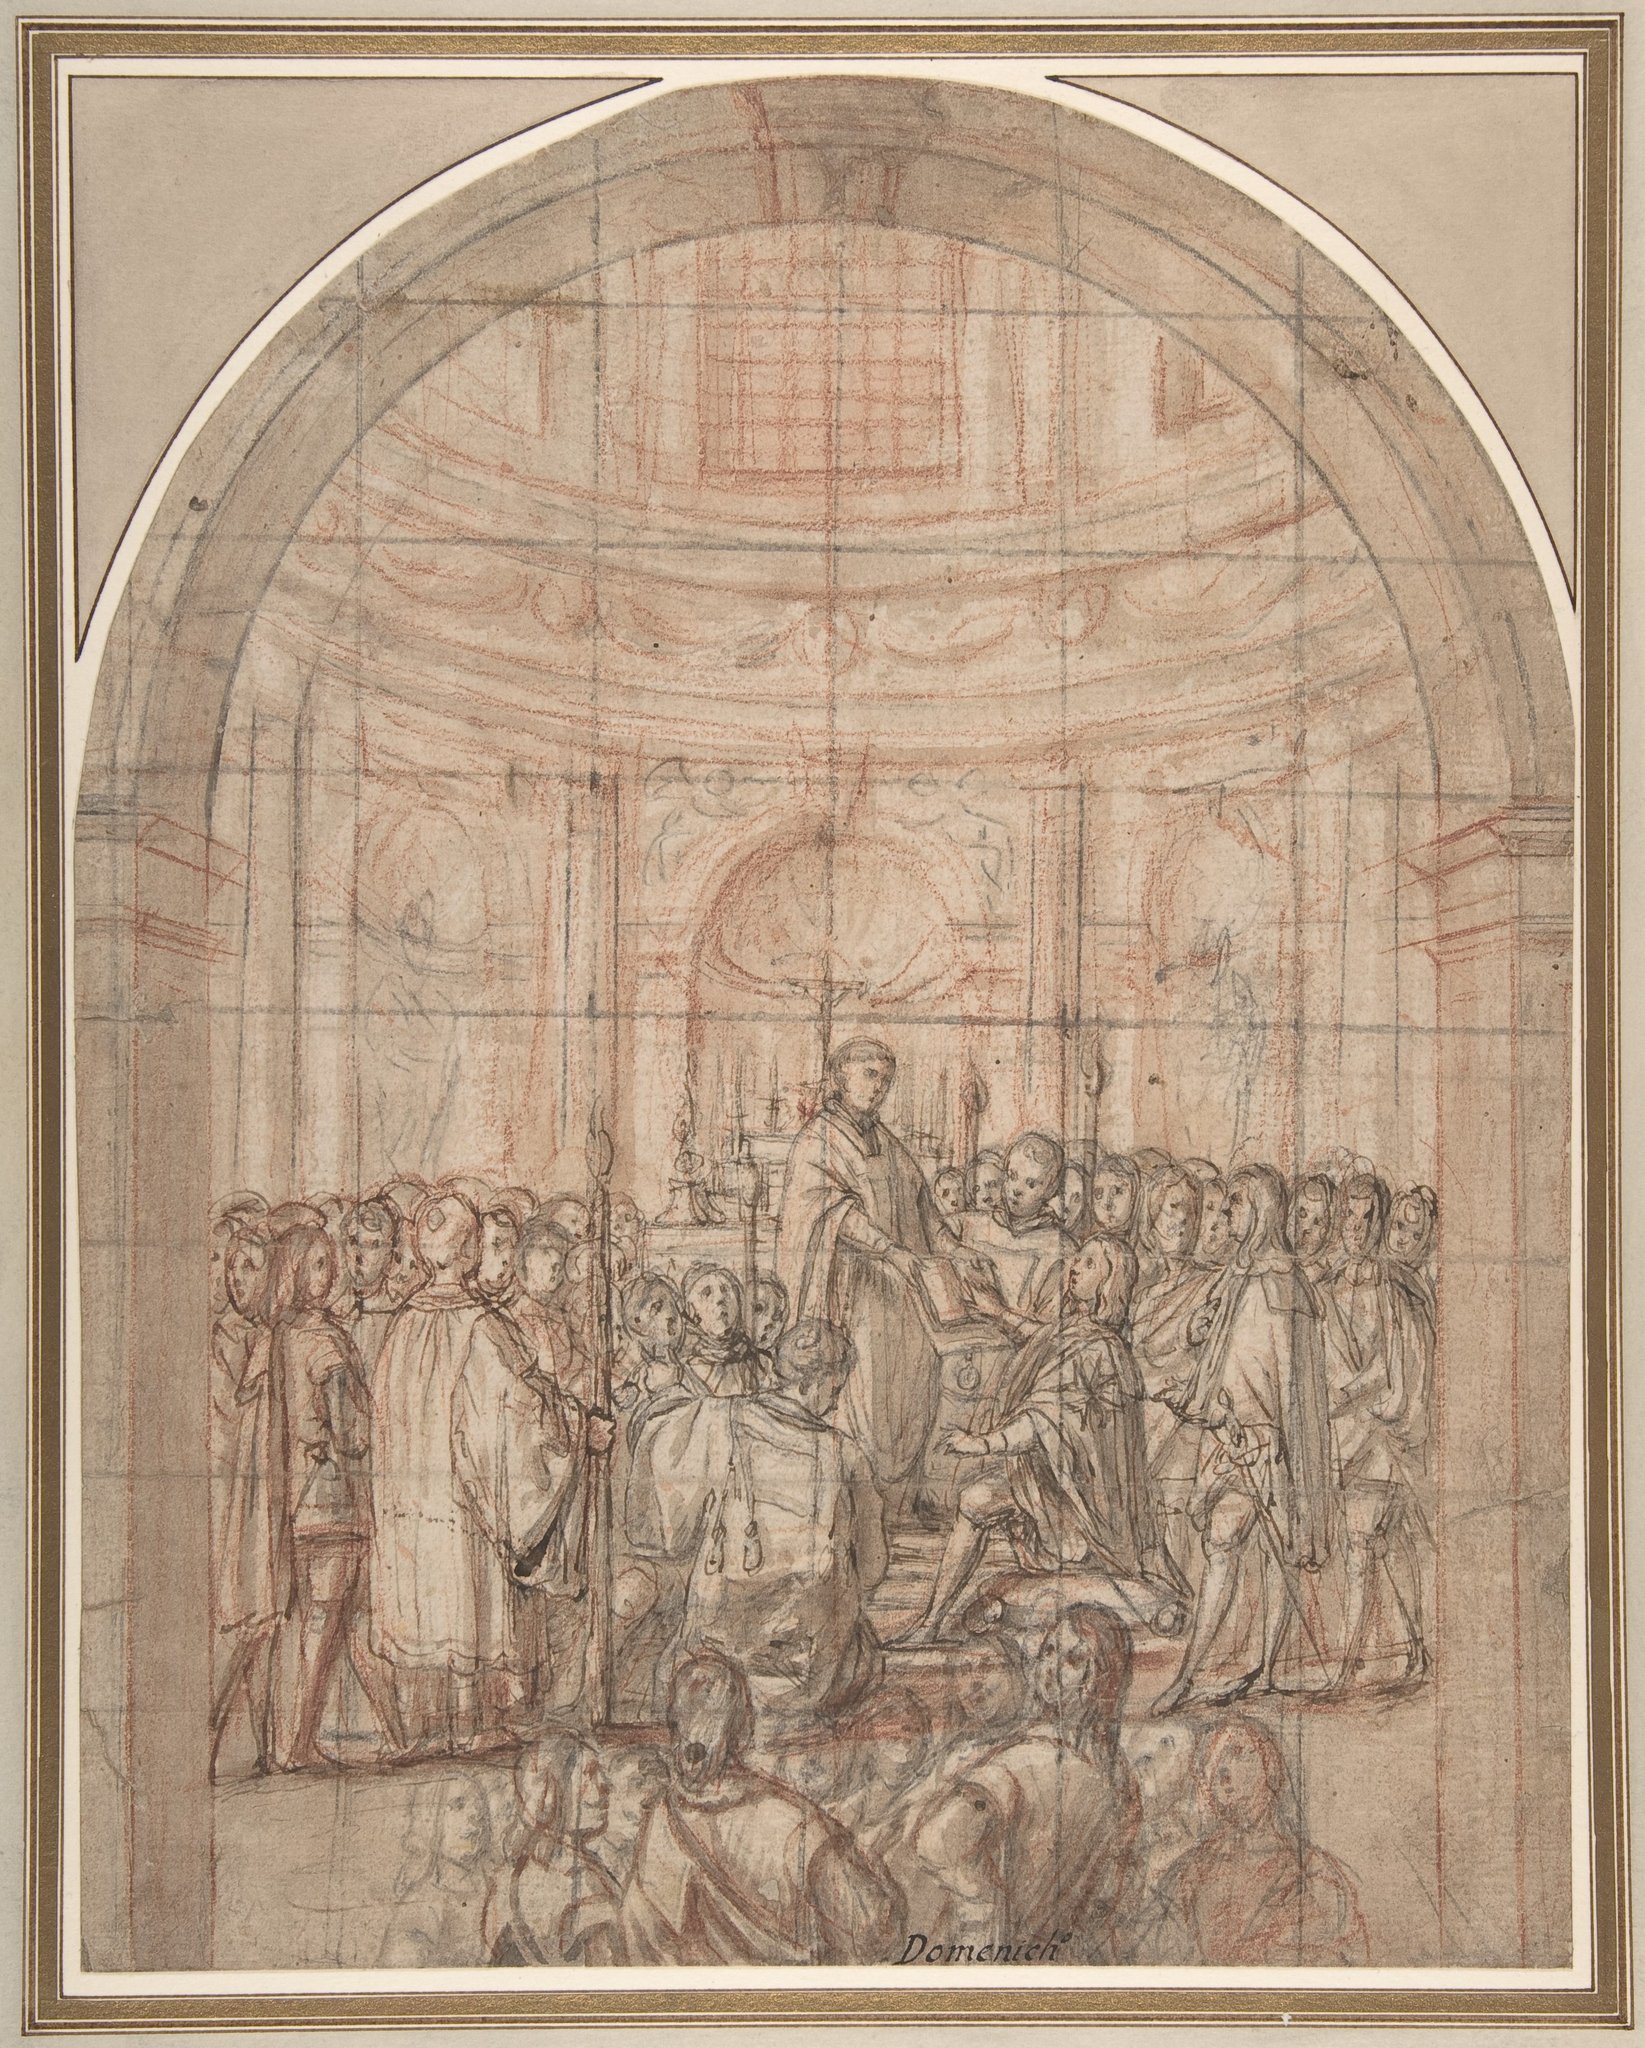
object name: drawing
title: The Swearing In of a Knight of the Tuscan Order of Saint Stephen (or Malta)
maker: anonymous, italian, 17th century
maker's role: artist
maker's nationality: italian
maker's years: 1600-1700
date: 1600-1620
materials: chalk, ink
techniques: brush, pen, drawing, wash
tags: men,crowd,knights